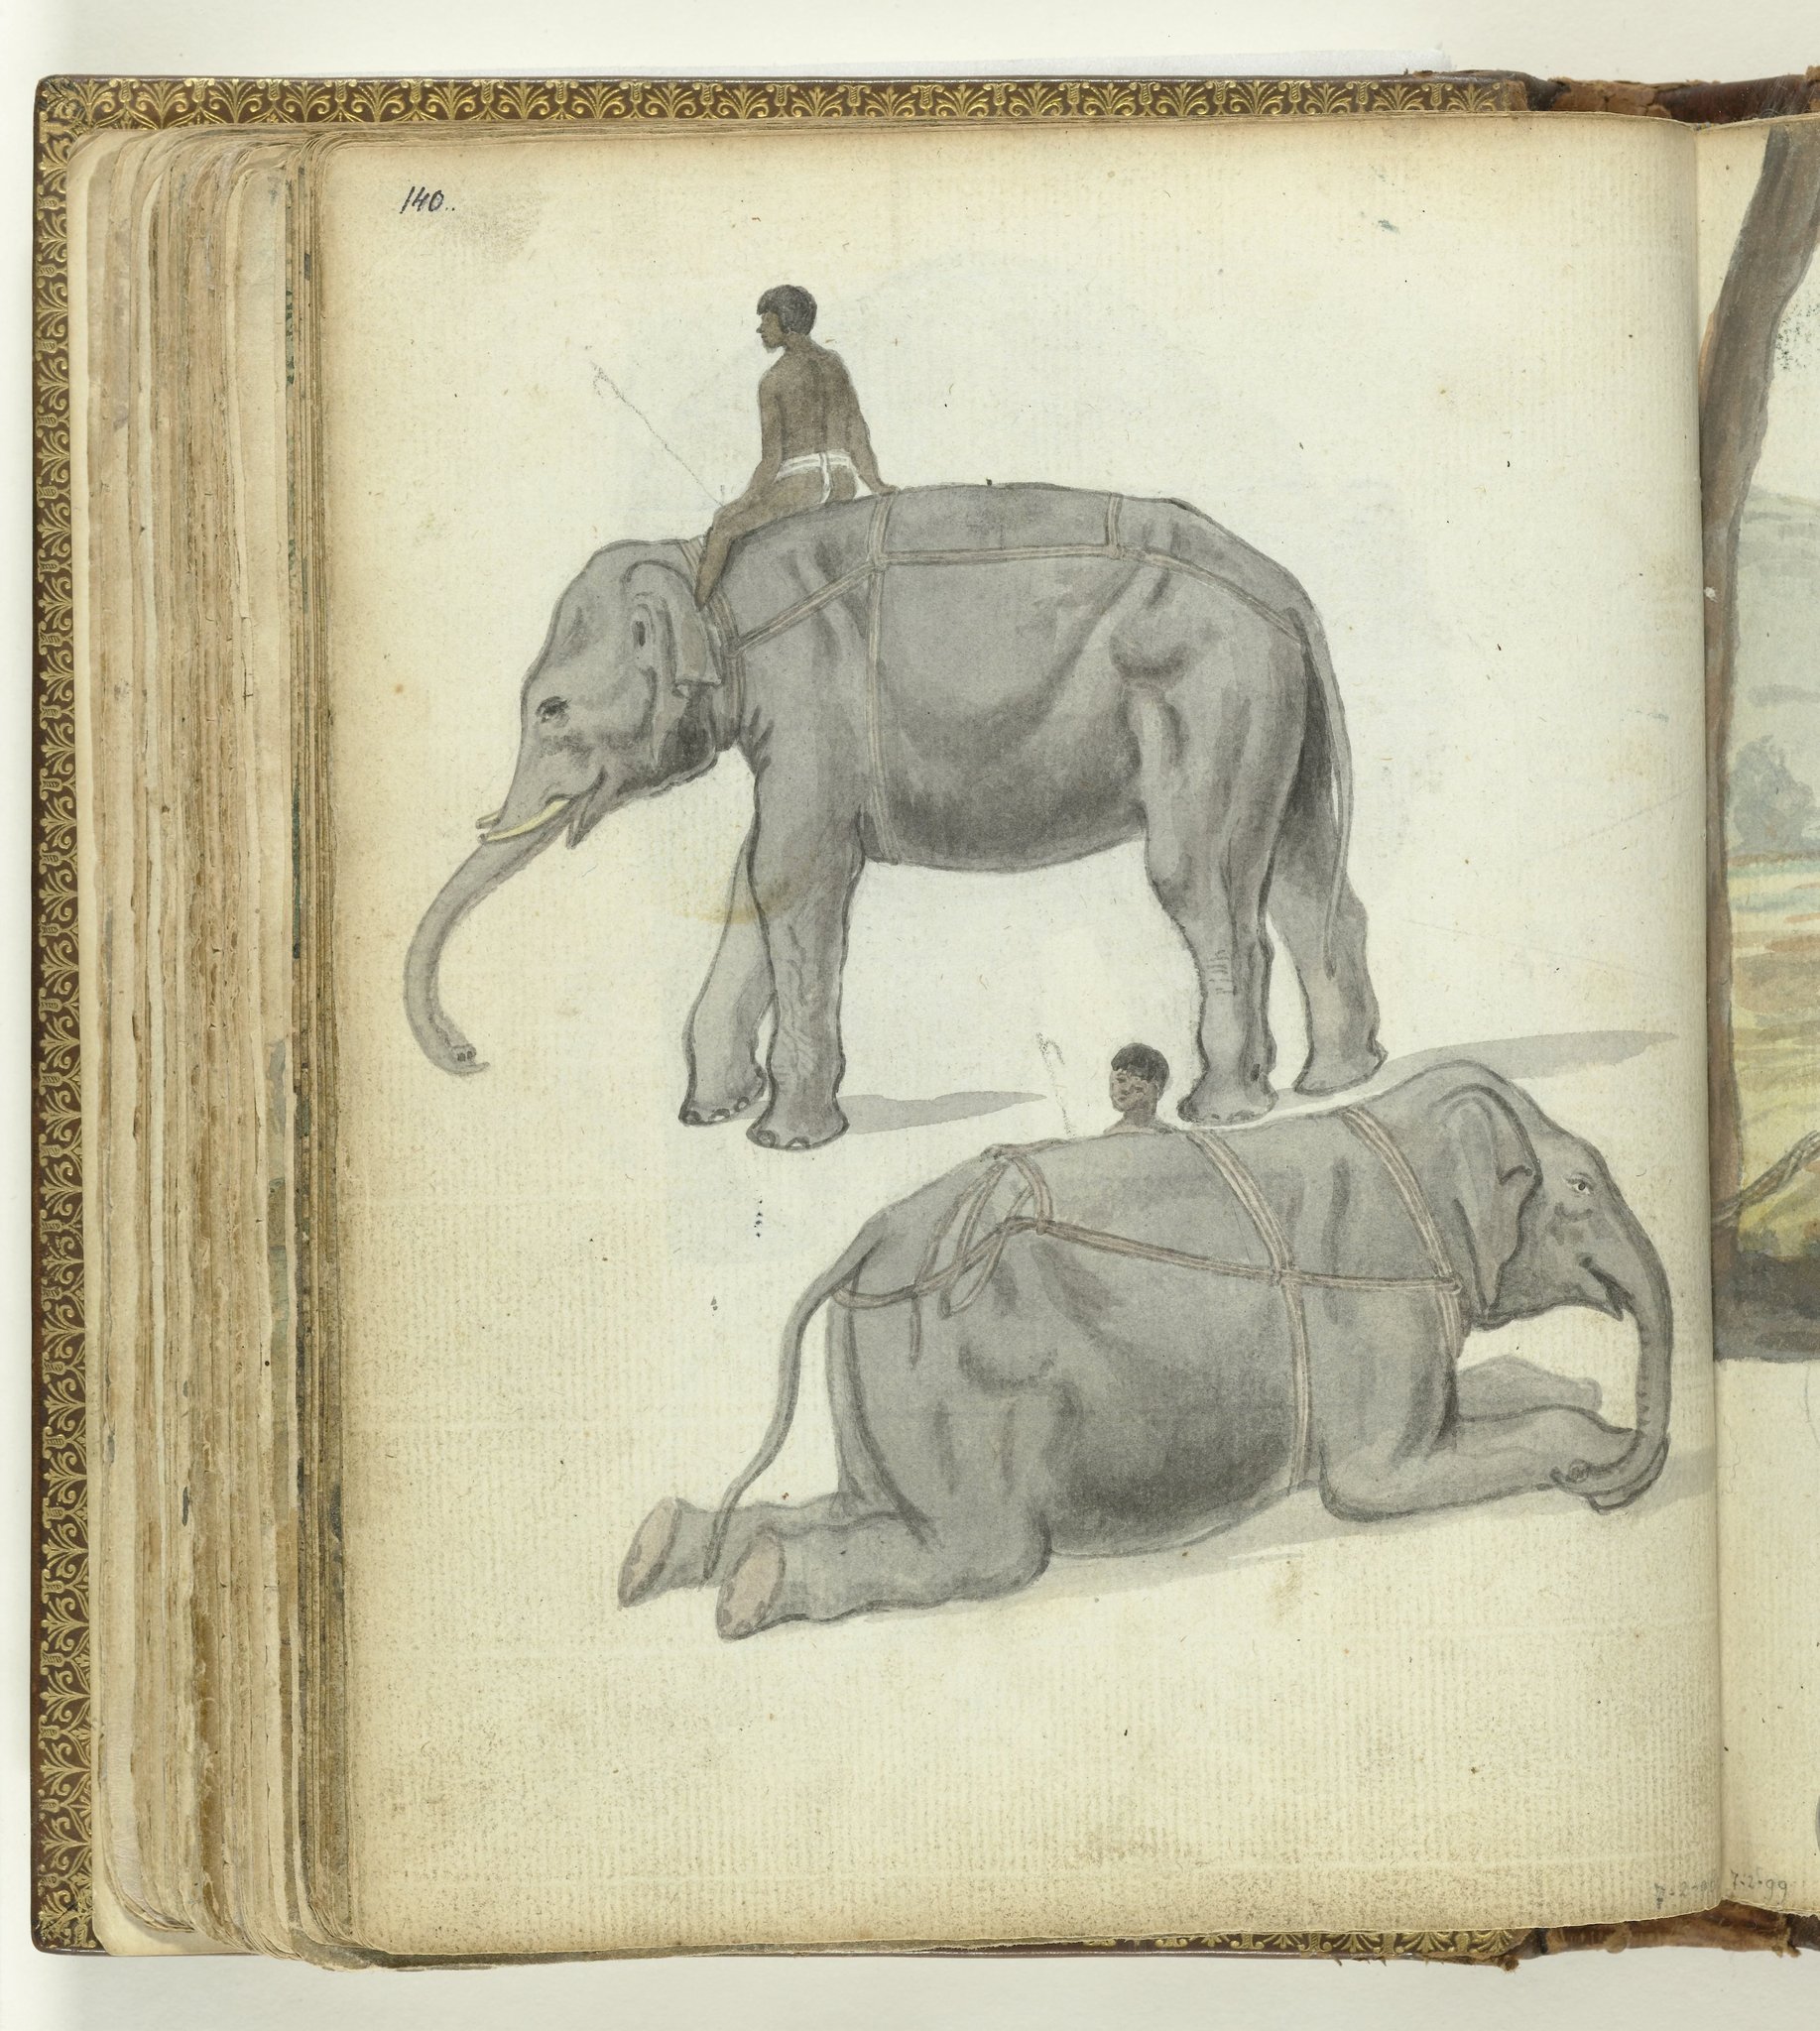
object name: drawing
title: Olifant in tuig staand en liggend.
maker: jan brandes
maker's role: draughtsman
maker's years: 1743-1808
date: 1712-1785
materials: ink, paper, pencil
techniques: brush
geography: ja-ela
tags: trunked animals: elephant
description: Penseeltekening van een olifant met temmer met piek. Onderdeel uit het schetsboek van Jan Brandes, dl. 2 (1808), p. 140.